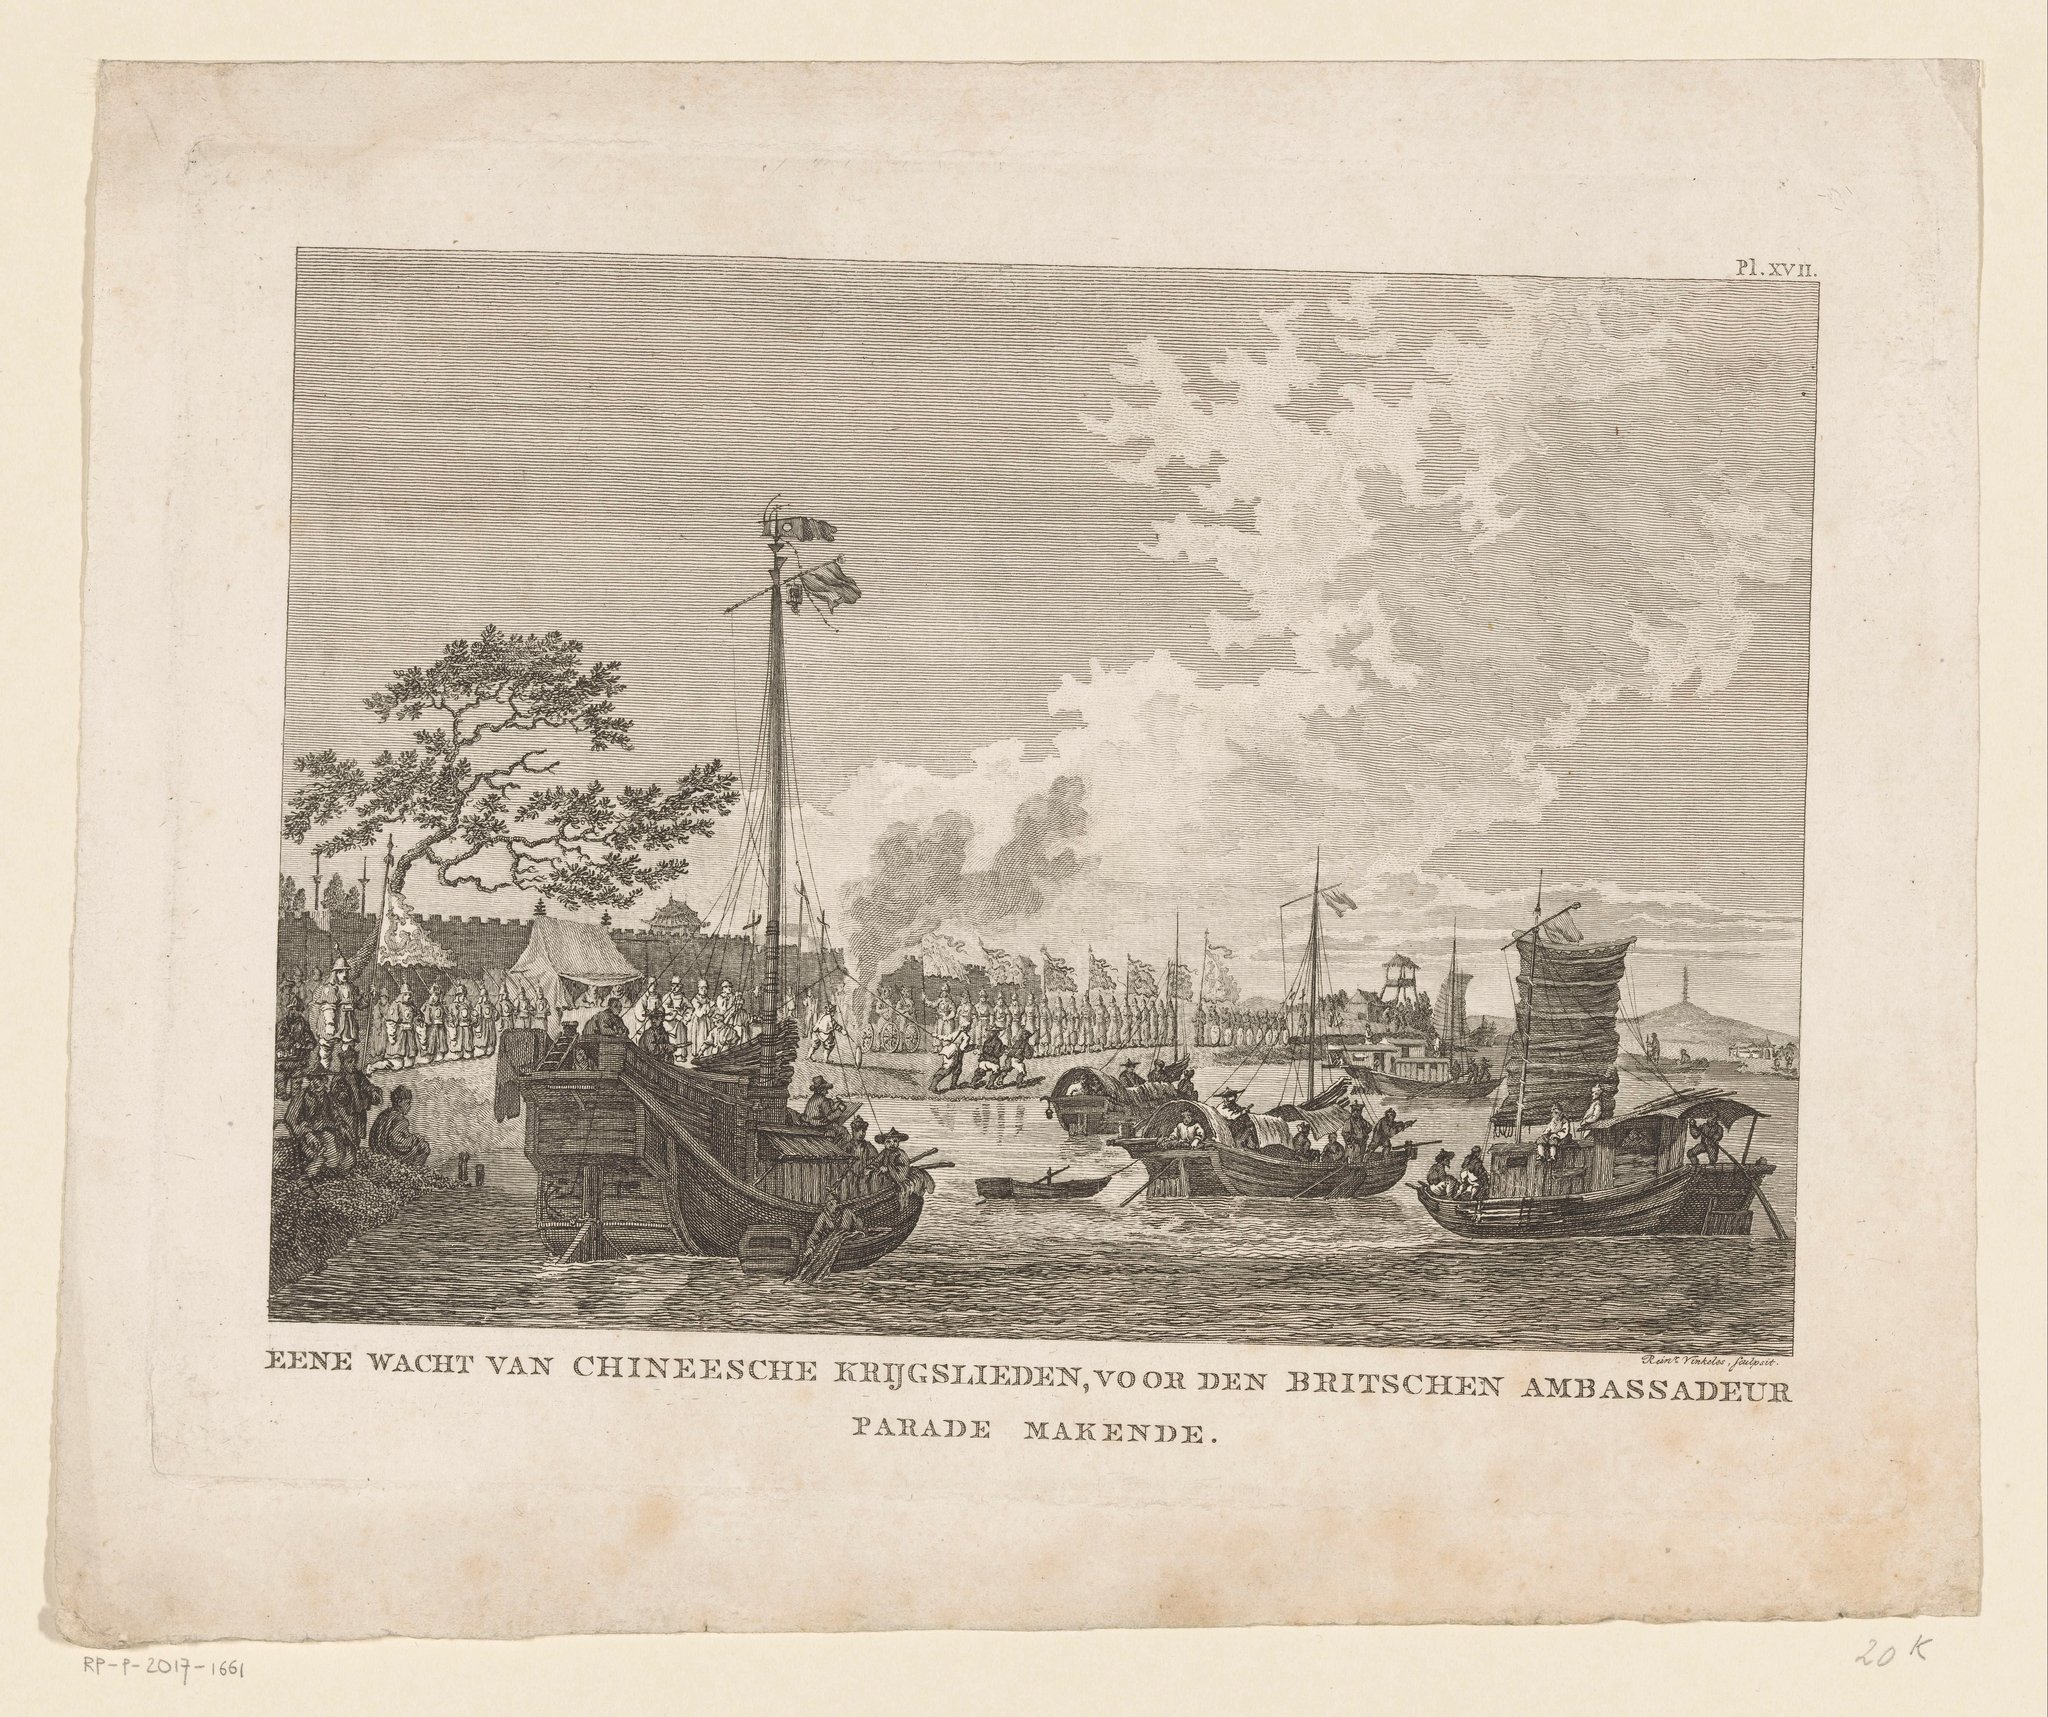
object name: print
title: Parade van Chinese krijgslieden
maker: reinier vinkeles (i)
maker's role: draughtsman, print maker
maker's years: 1741-1816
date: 1751-1816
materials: paper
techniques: engraving, etching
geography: amsterdam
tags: asiatic races and peoples, sailing-ship, sailing-boat, military parade, pageant